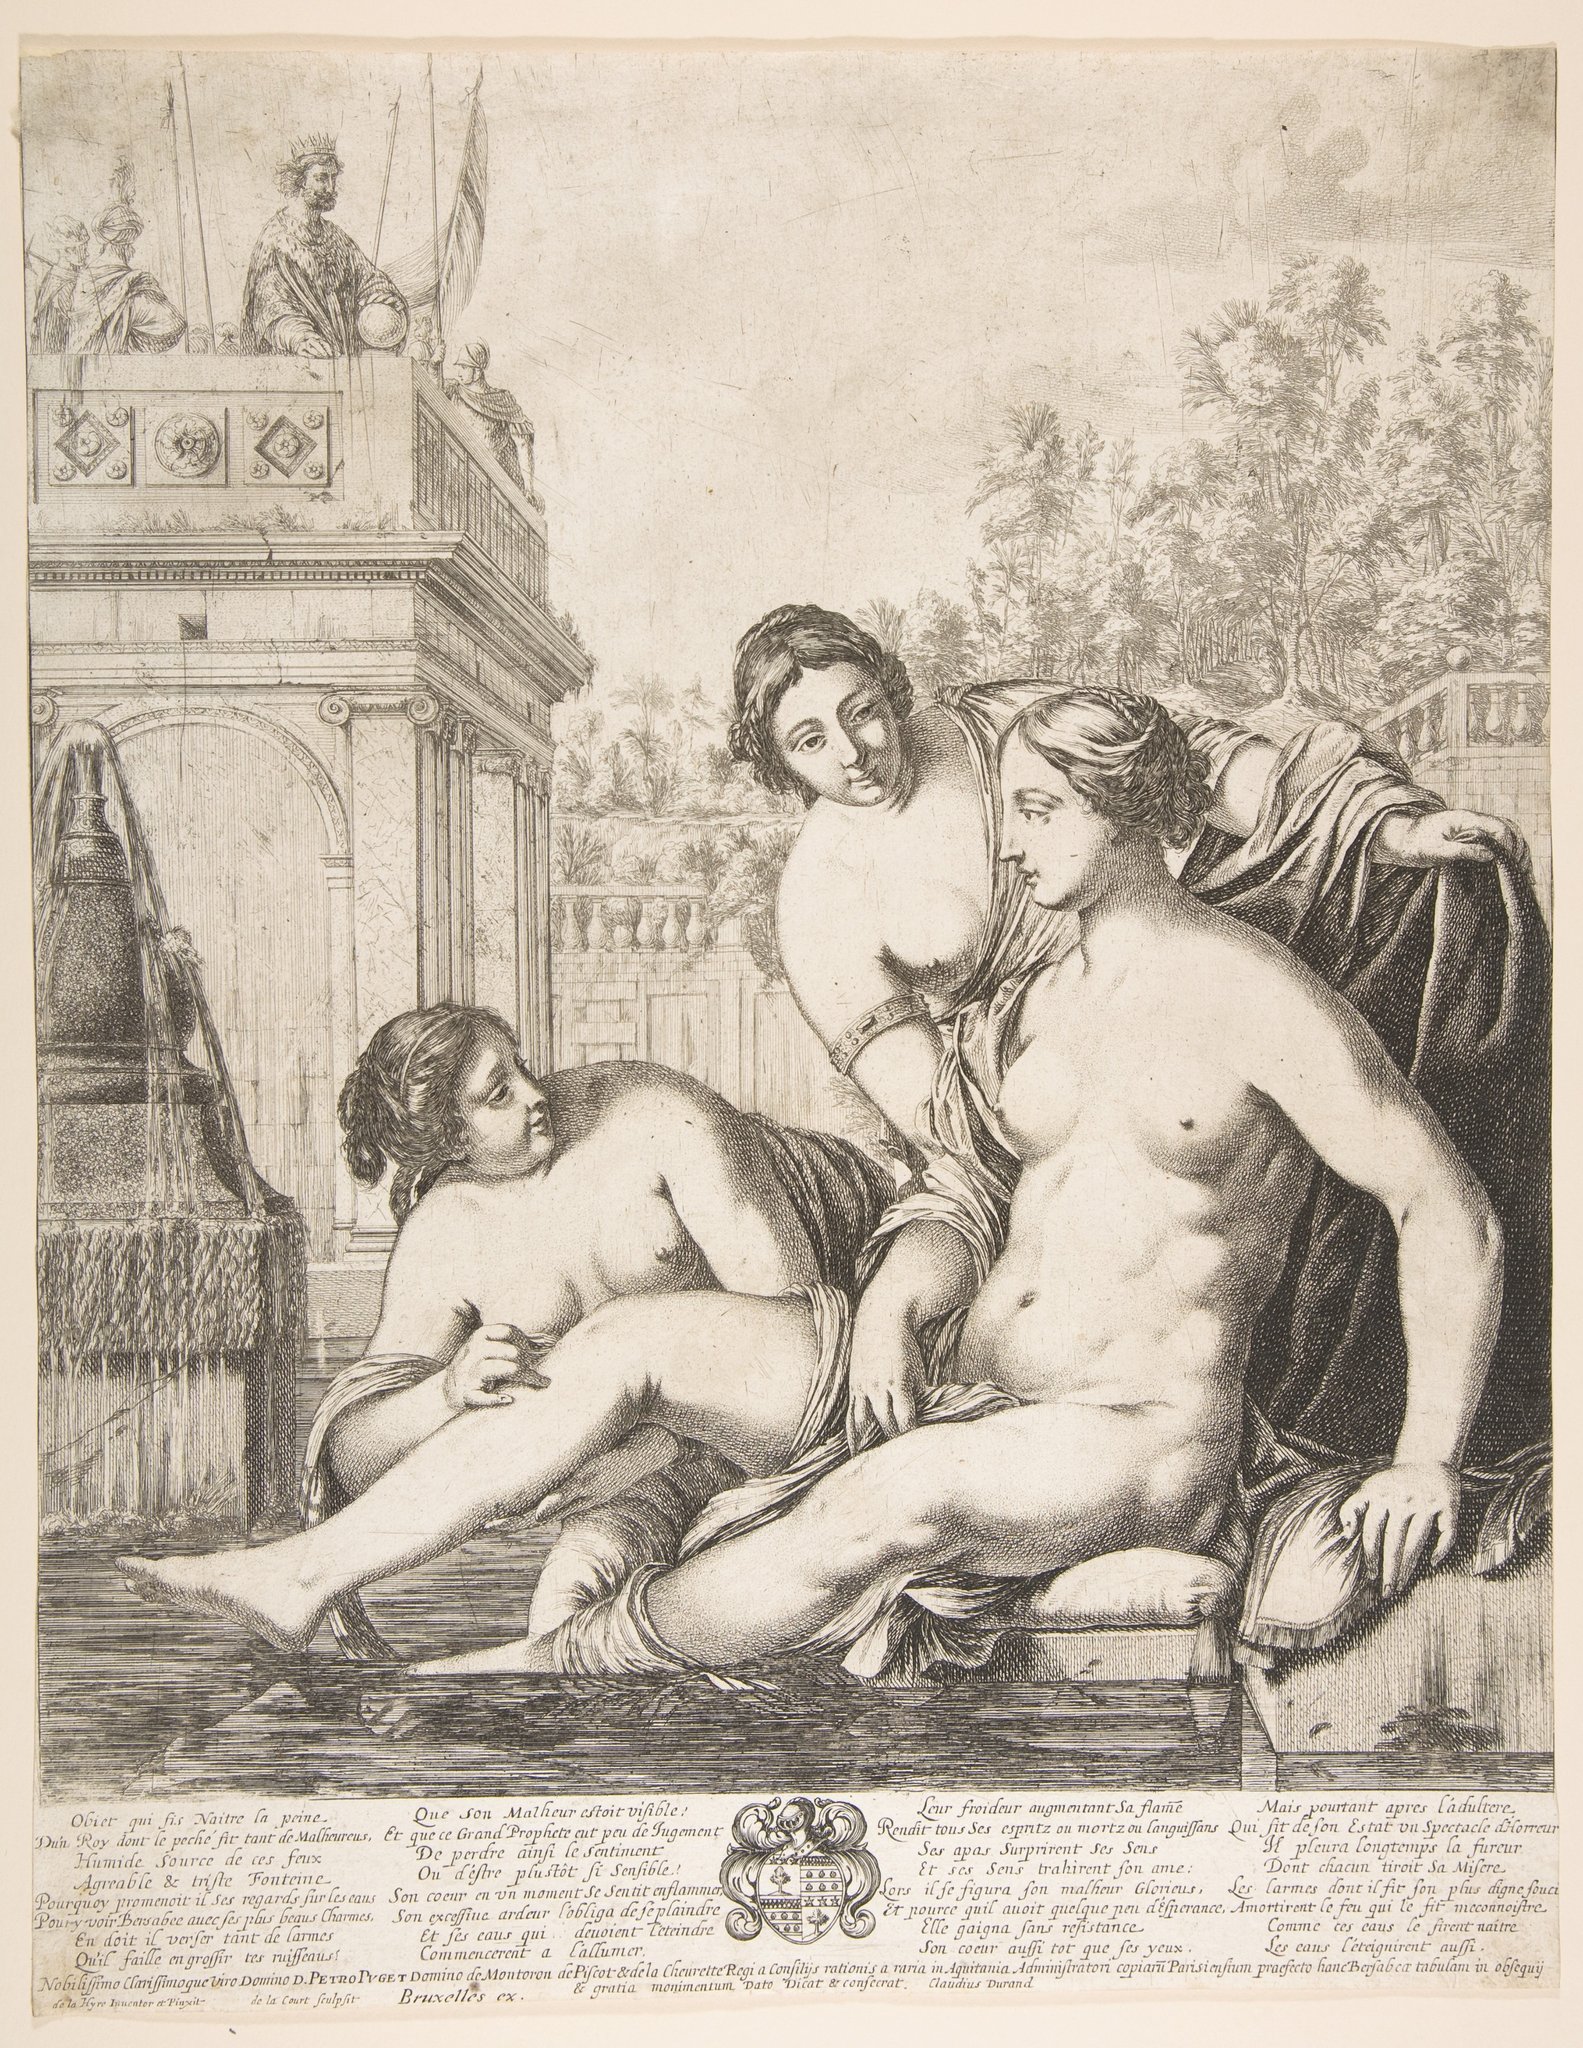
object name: print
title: David Watching Bathsheba Bathe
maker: de la court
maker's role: artist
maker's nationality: french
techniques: engraving, etching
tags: bathsheba,david,bathing,coat of arms